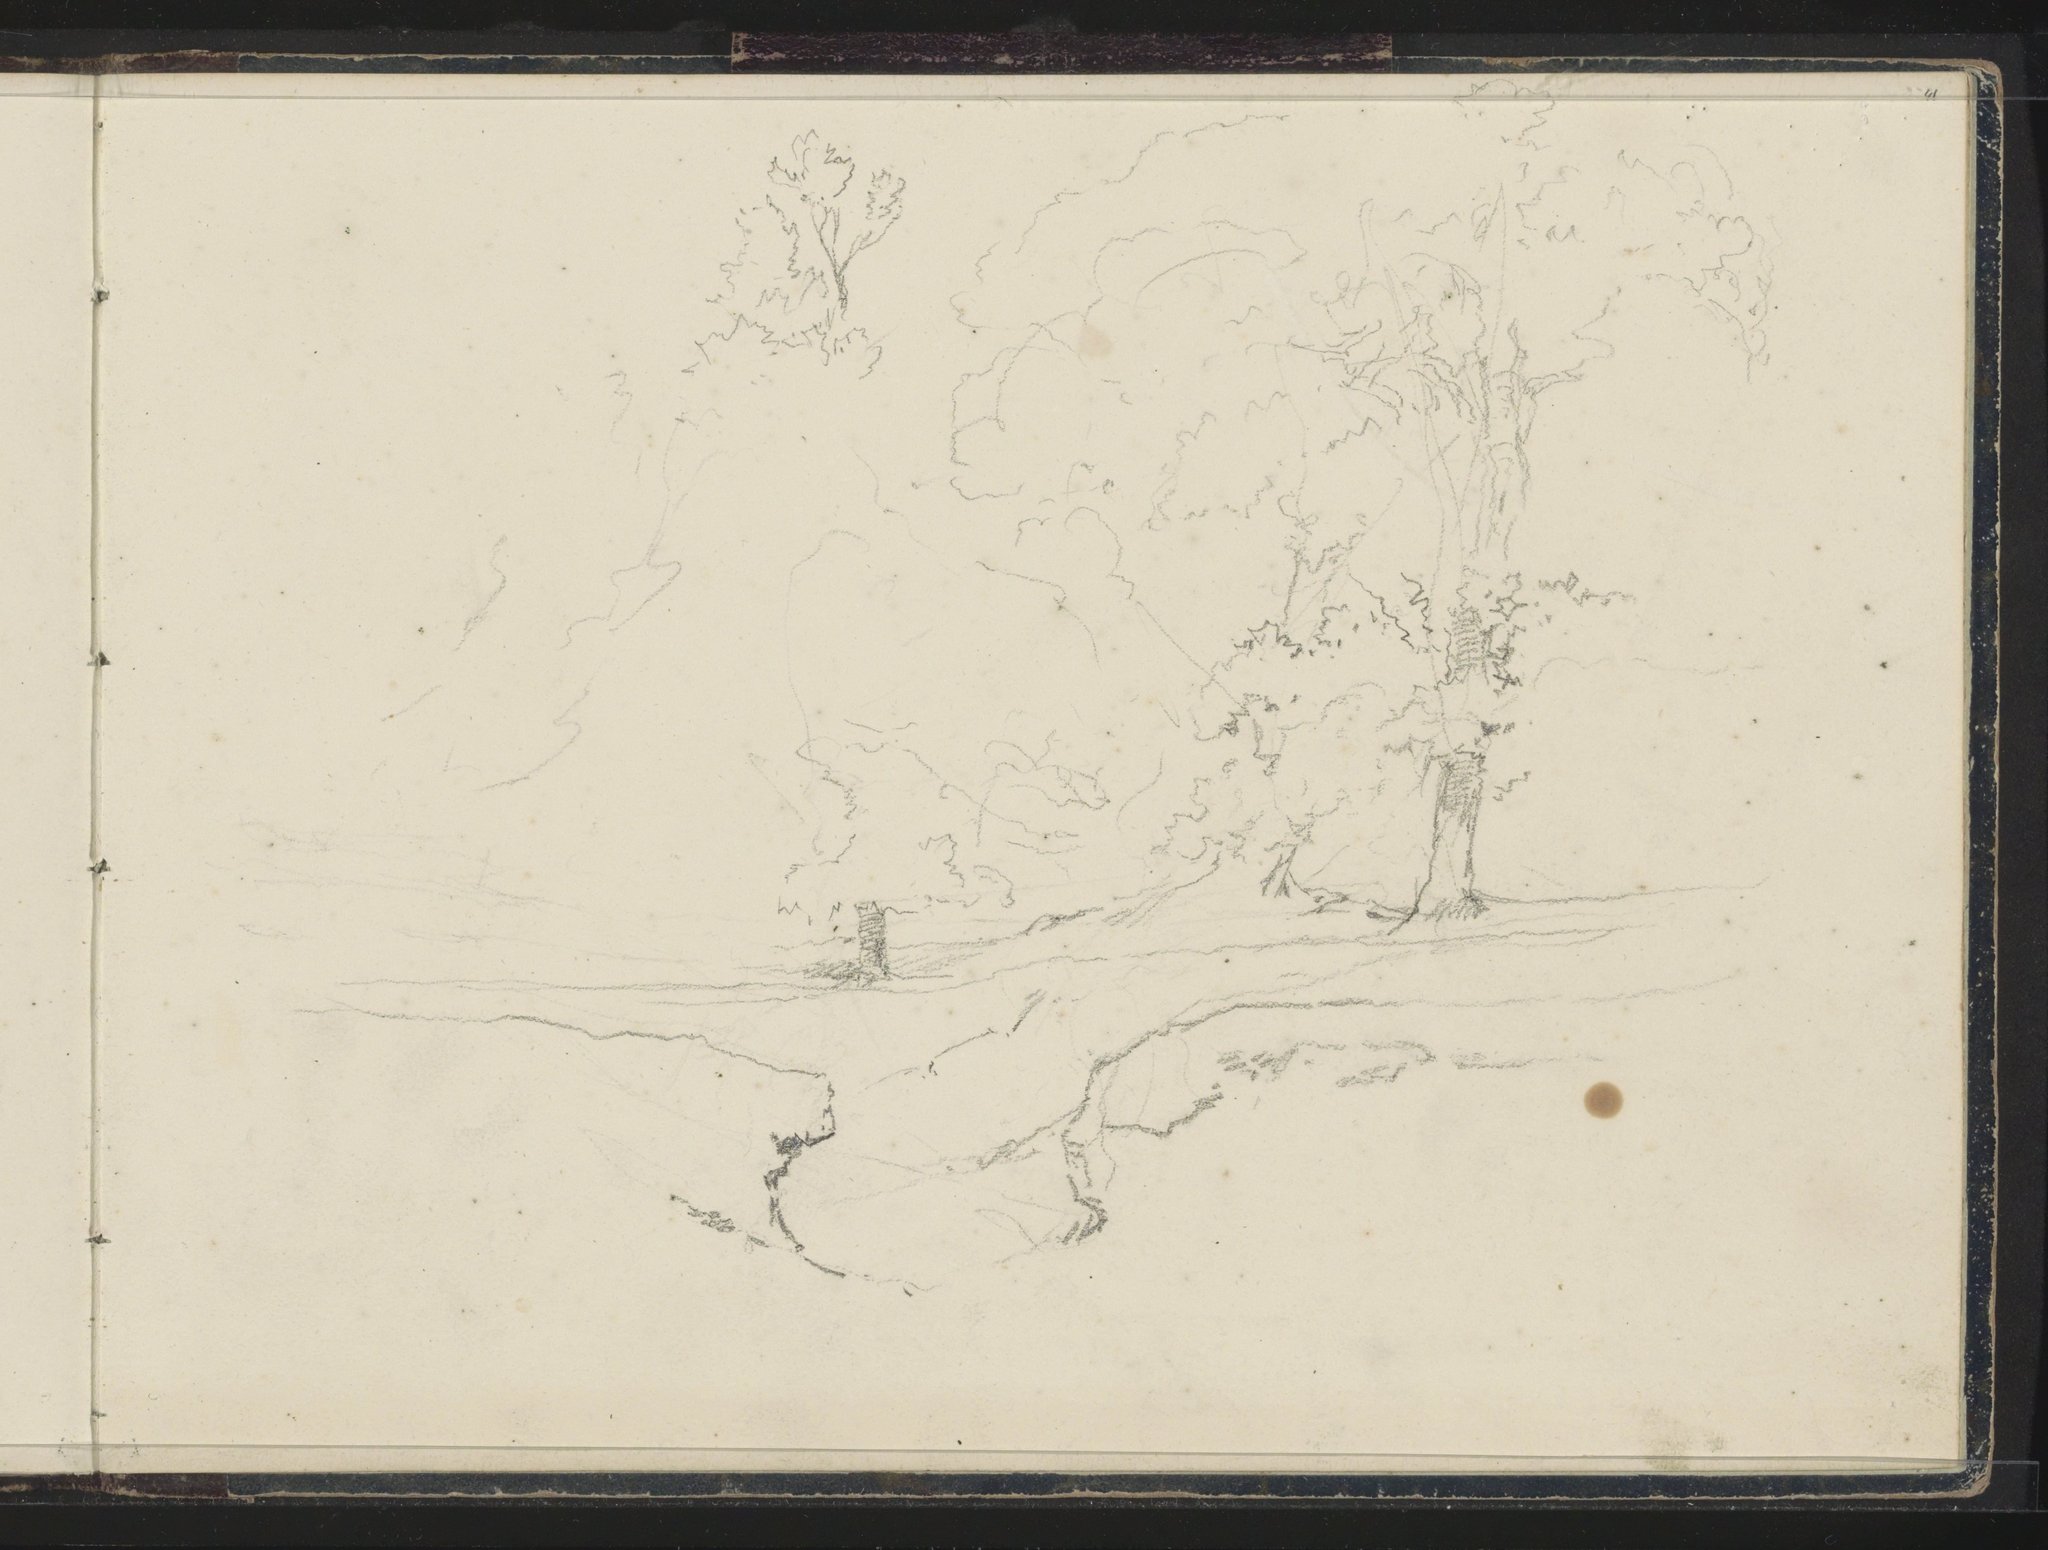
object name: sketchbook leaf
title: Landschap met bomen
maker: maria vos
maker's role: draughtsman, painter, print maker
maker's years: 1824-1906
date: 1864-1865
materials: paper, pencil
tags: landscapes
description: Blad 41 recto uit een schetsboek met 44 bladen.